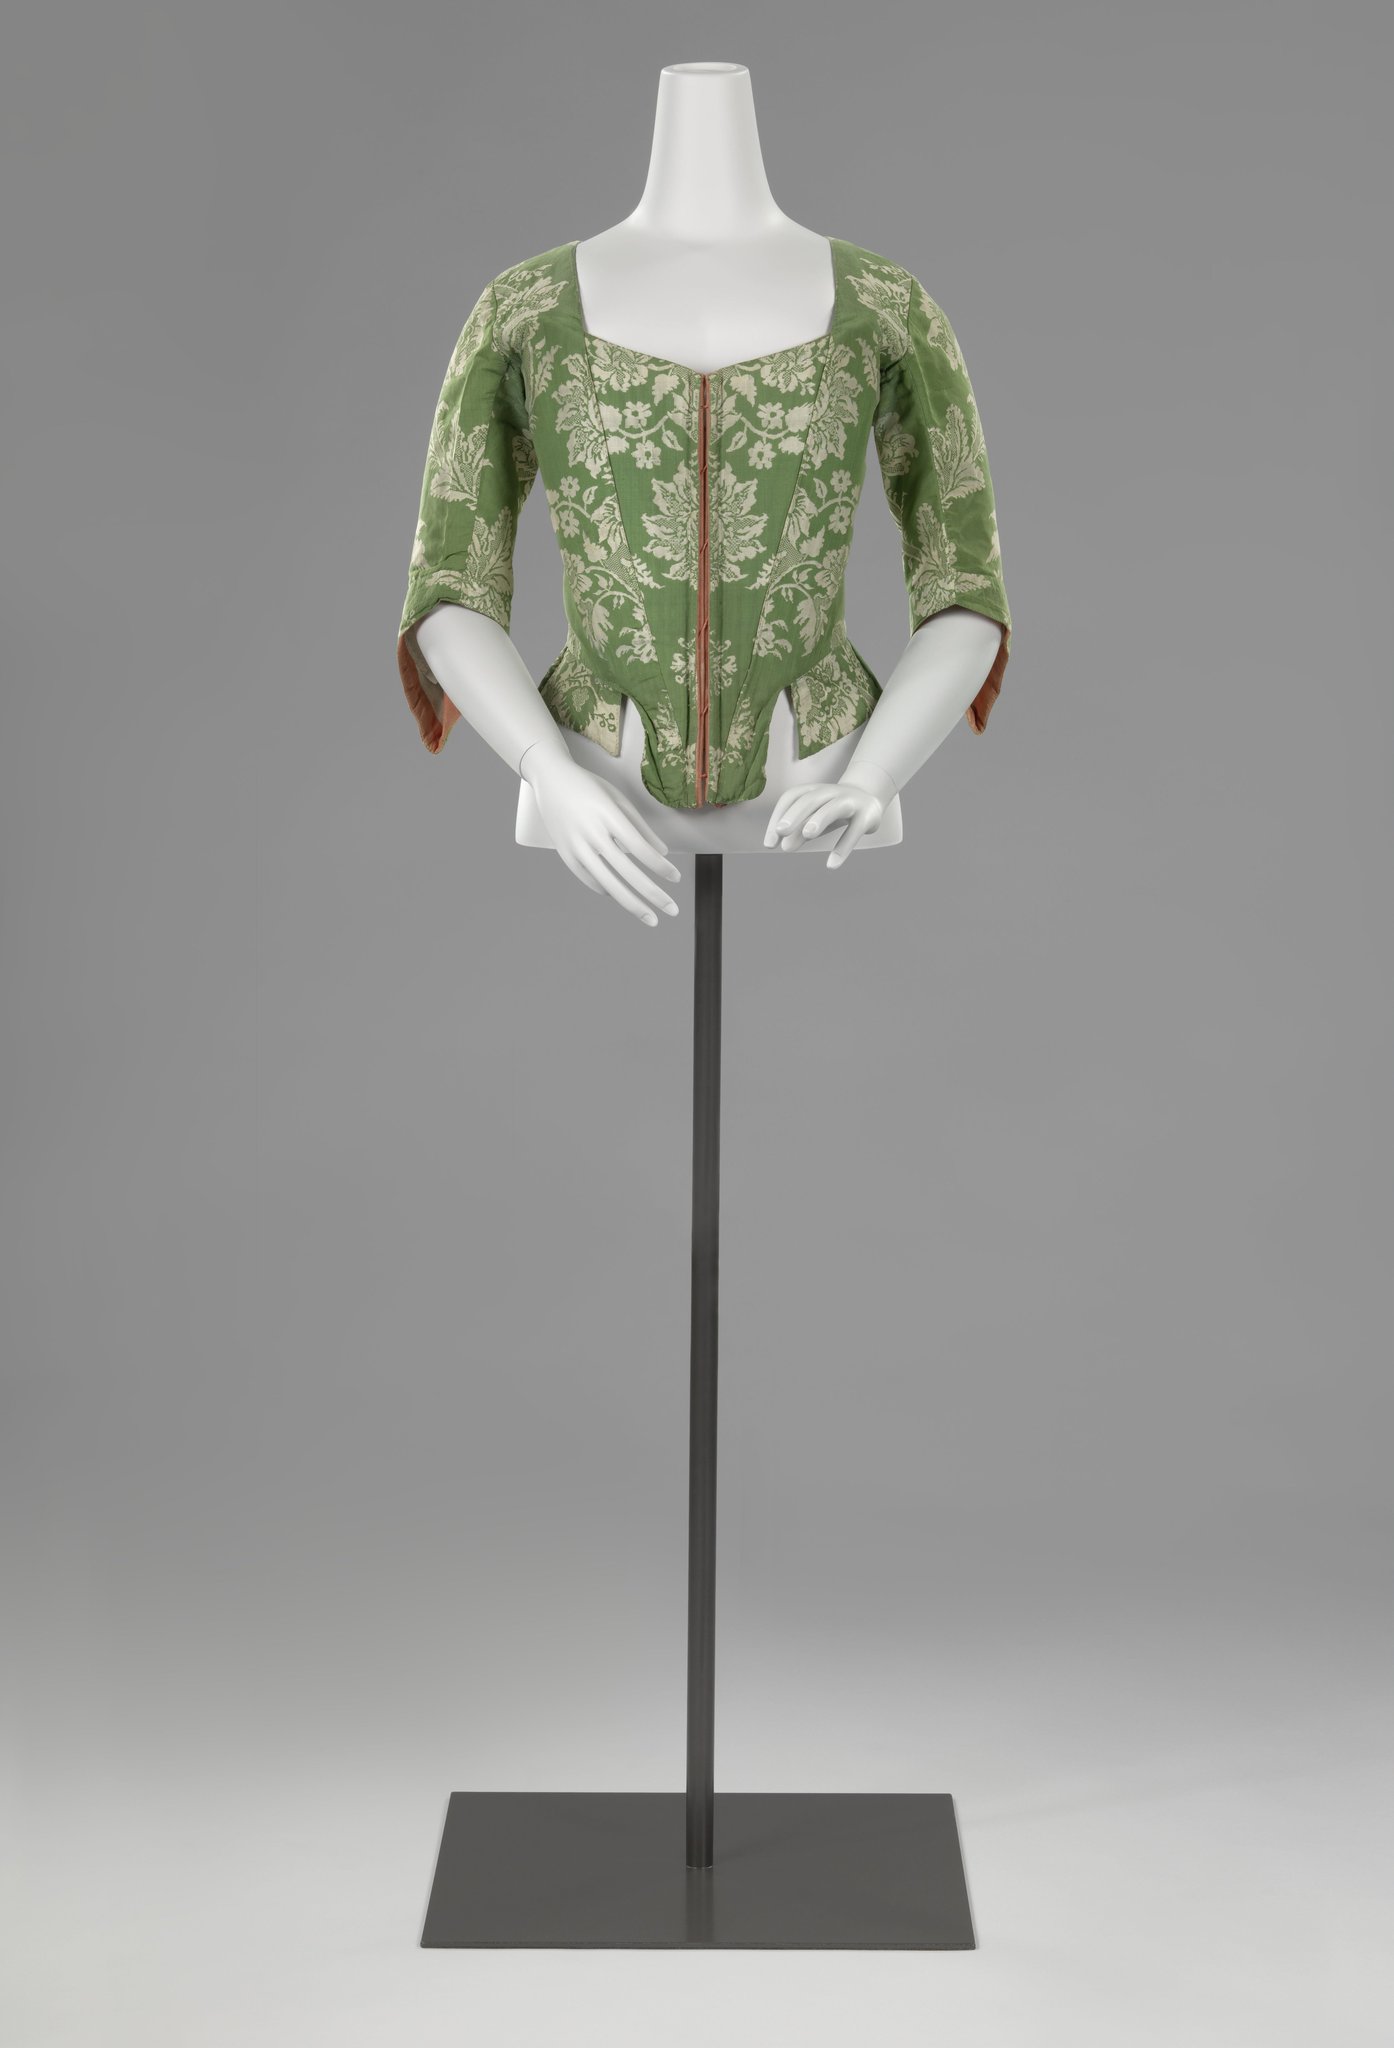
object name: corsage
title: Keurslijf of rijglijf van zijde met witte bloemen op grasgroen fond, vierkante hals, halflange mouwen met 'manches à racquette', voorpanden voorzien van baleinen en busque, linnen voering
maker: Anonymous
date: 1750-1770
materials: leather, linen, silk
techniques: tanning, weave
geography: netherlands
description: Keurslijf of rijglijf van zijde met een grasgroen fond en witte bloemen, met vierkante hals, halflange mouwen met 'manches en racquette', voorpanden geheel voorzien van baleinen en busque, linnen voering. Model: voorpanden samengesteld uit twee delen, waarvan éen deel zonder schoudernaad doorloopt in het achterpand. Het achterpand bestaat uit één stuk zijde. Aan de rechte zoom is een gedeeltelijk gevouwen schootje gezet, dat midden achter eindigt in een ovaalachtige vorm. Aan beide voorpanden zijn middenvoor tegen de blinde sluiting, van zes met groene zijde gefestonneerde ogen, op elkaar twee verticale busks van 6 mm geplaatst, die aan de boven- en onderkant zijn voorzien van zeemleer. Dit zeemleer loopt langs de gehele onderkant van de baleinen en rond de armsgaten. De naar het midden taps toelopende baleinen zijn in een grove linnen stof gewerkt en voorzien van twee, op gelijke afstand geplaatstse, horizontale baleinen. Op de baleinen is aan weerszijden een band van grove groene linnen genaaid, om van voren te knopen. Versiering: langs de busks en de in de mouwopeningen is rode zijde genaaid.